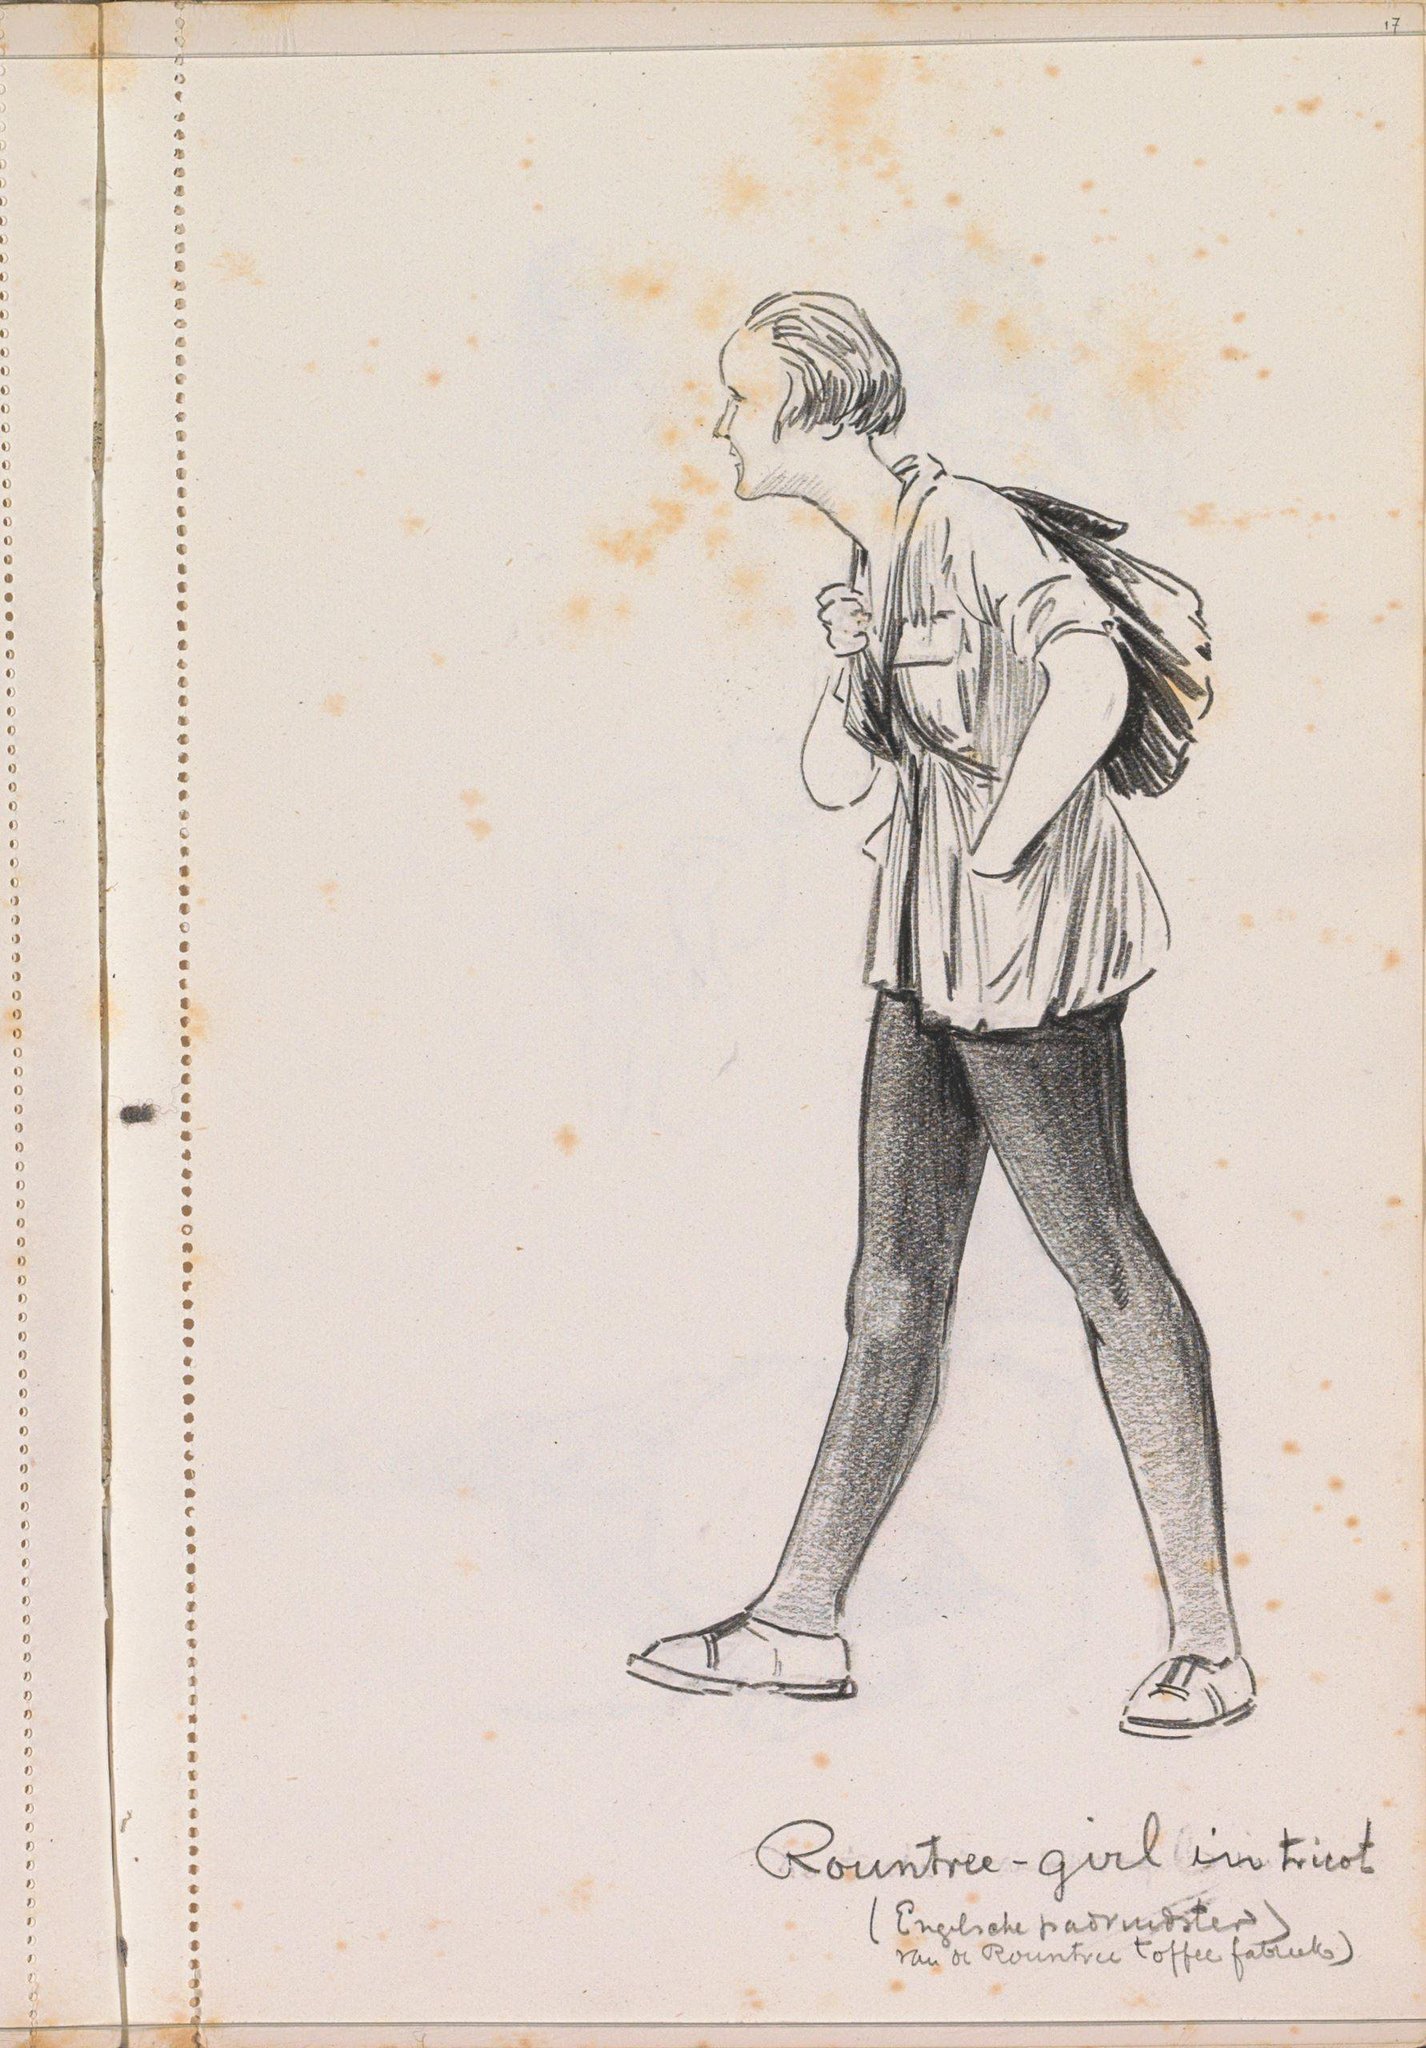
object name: sketchbook leaf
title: Engelse padvindster van de Rowntree toffeefabriek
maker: otto verhagen (i)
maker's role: draughtsman, print maker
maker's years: 1885-1951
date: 1928-1930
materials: chalk, paper, pencil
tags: bag, girl (child between toddler and youth)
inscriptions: annotation: ‘Rowntree-girl in tricot/ (Engelsche padvindster)/ van de Rowntree toffee fabriek)’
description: Het meisje draagt een blouse en broek en heeft een rugzak op de rug. Pagina 17 uit een schetsboek met 51 bladen.